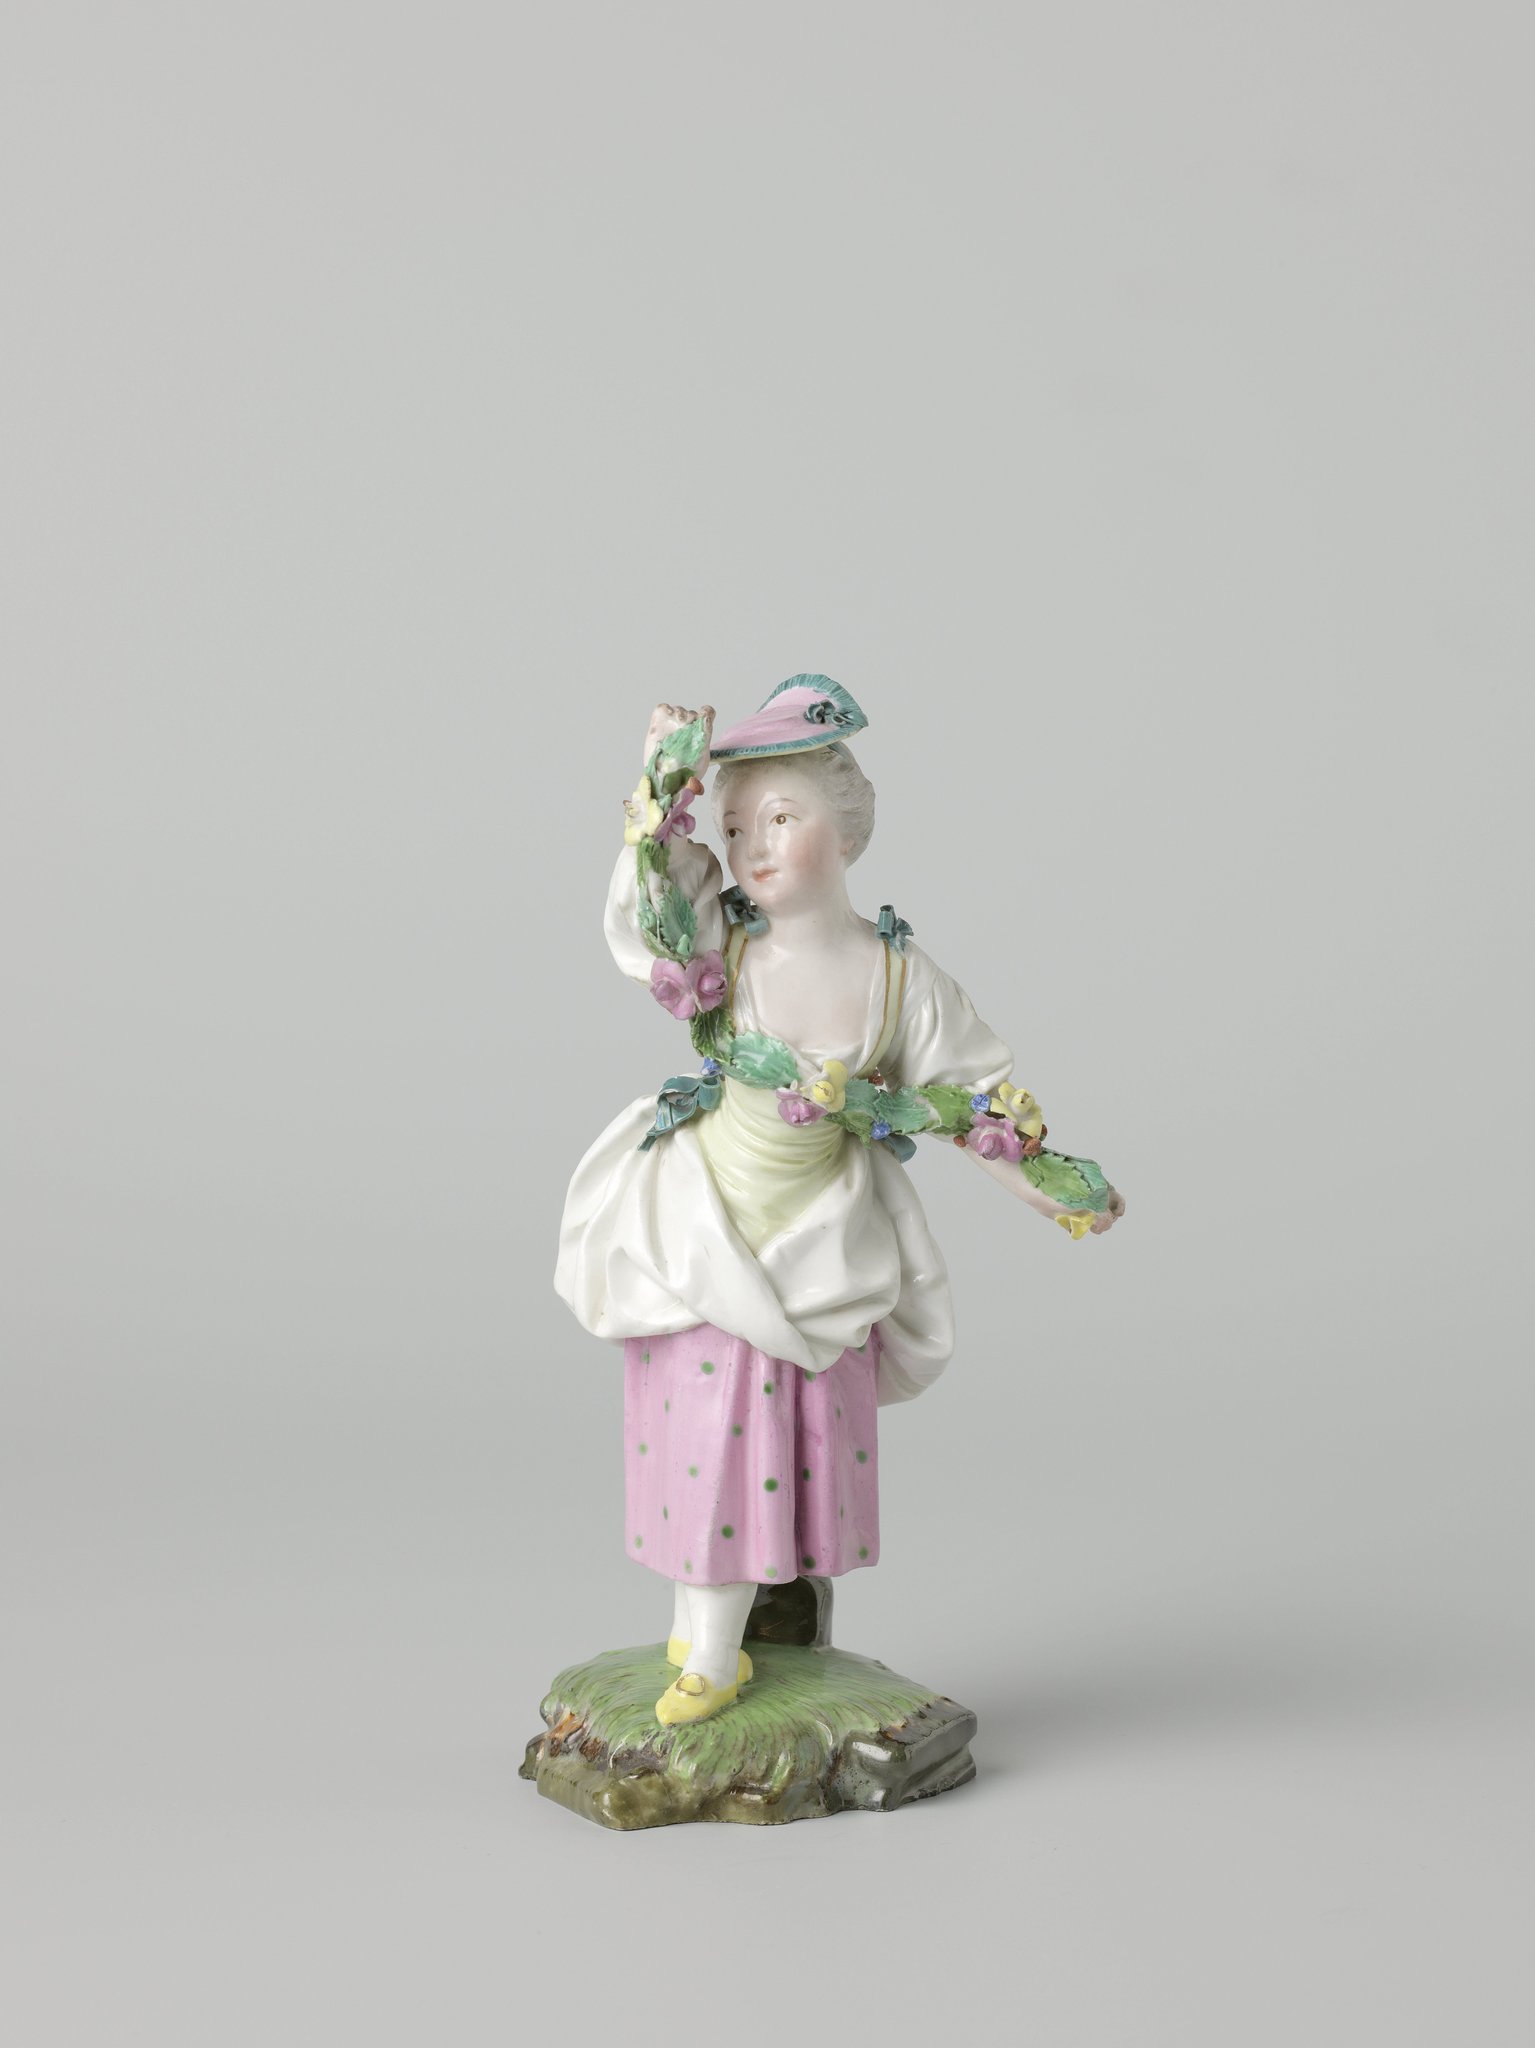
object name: figure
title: Figure of a dancing girl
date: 1767-1775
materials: glaze, gold, paint, porcelain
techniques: firing, forming, gilding, vitrification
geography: höchst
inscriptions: mark: ‘wiel/ MH’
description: Two figures. Porcelain. Höchst, c. 1767 - 1775.